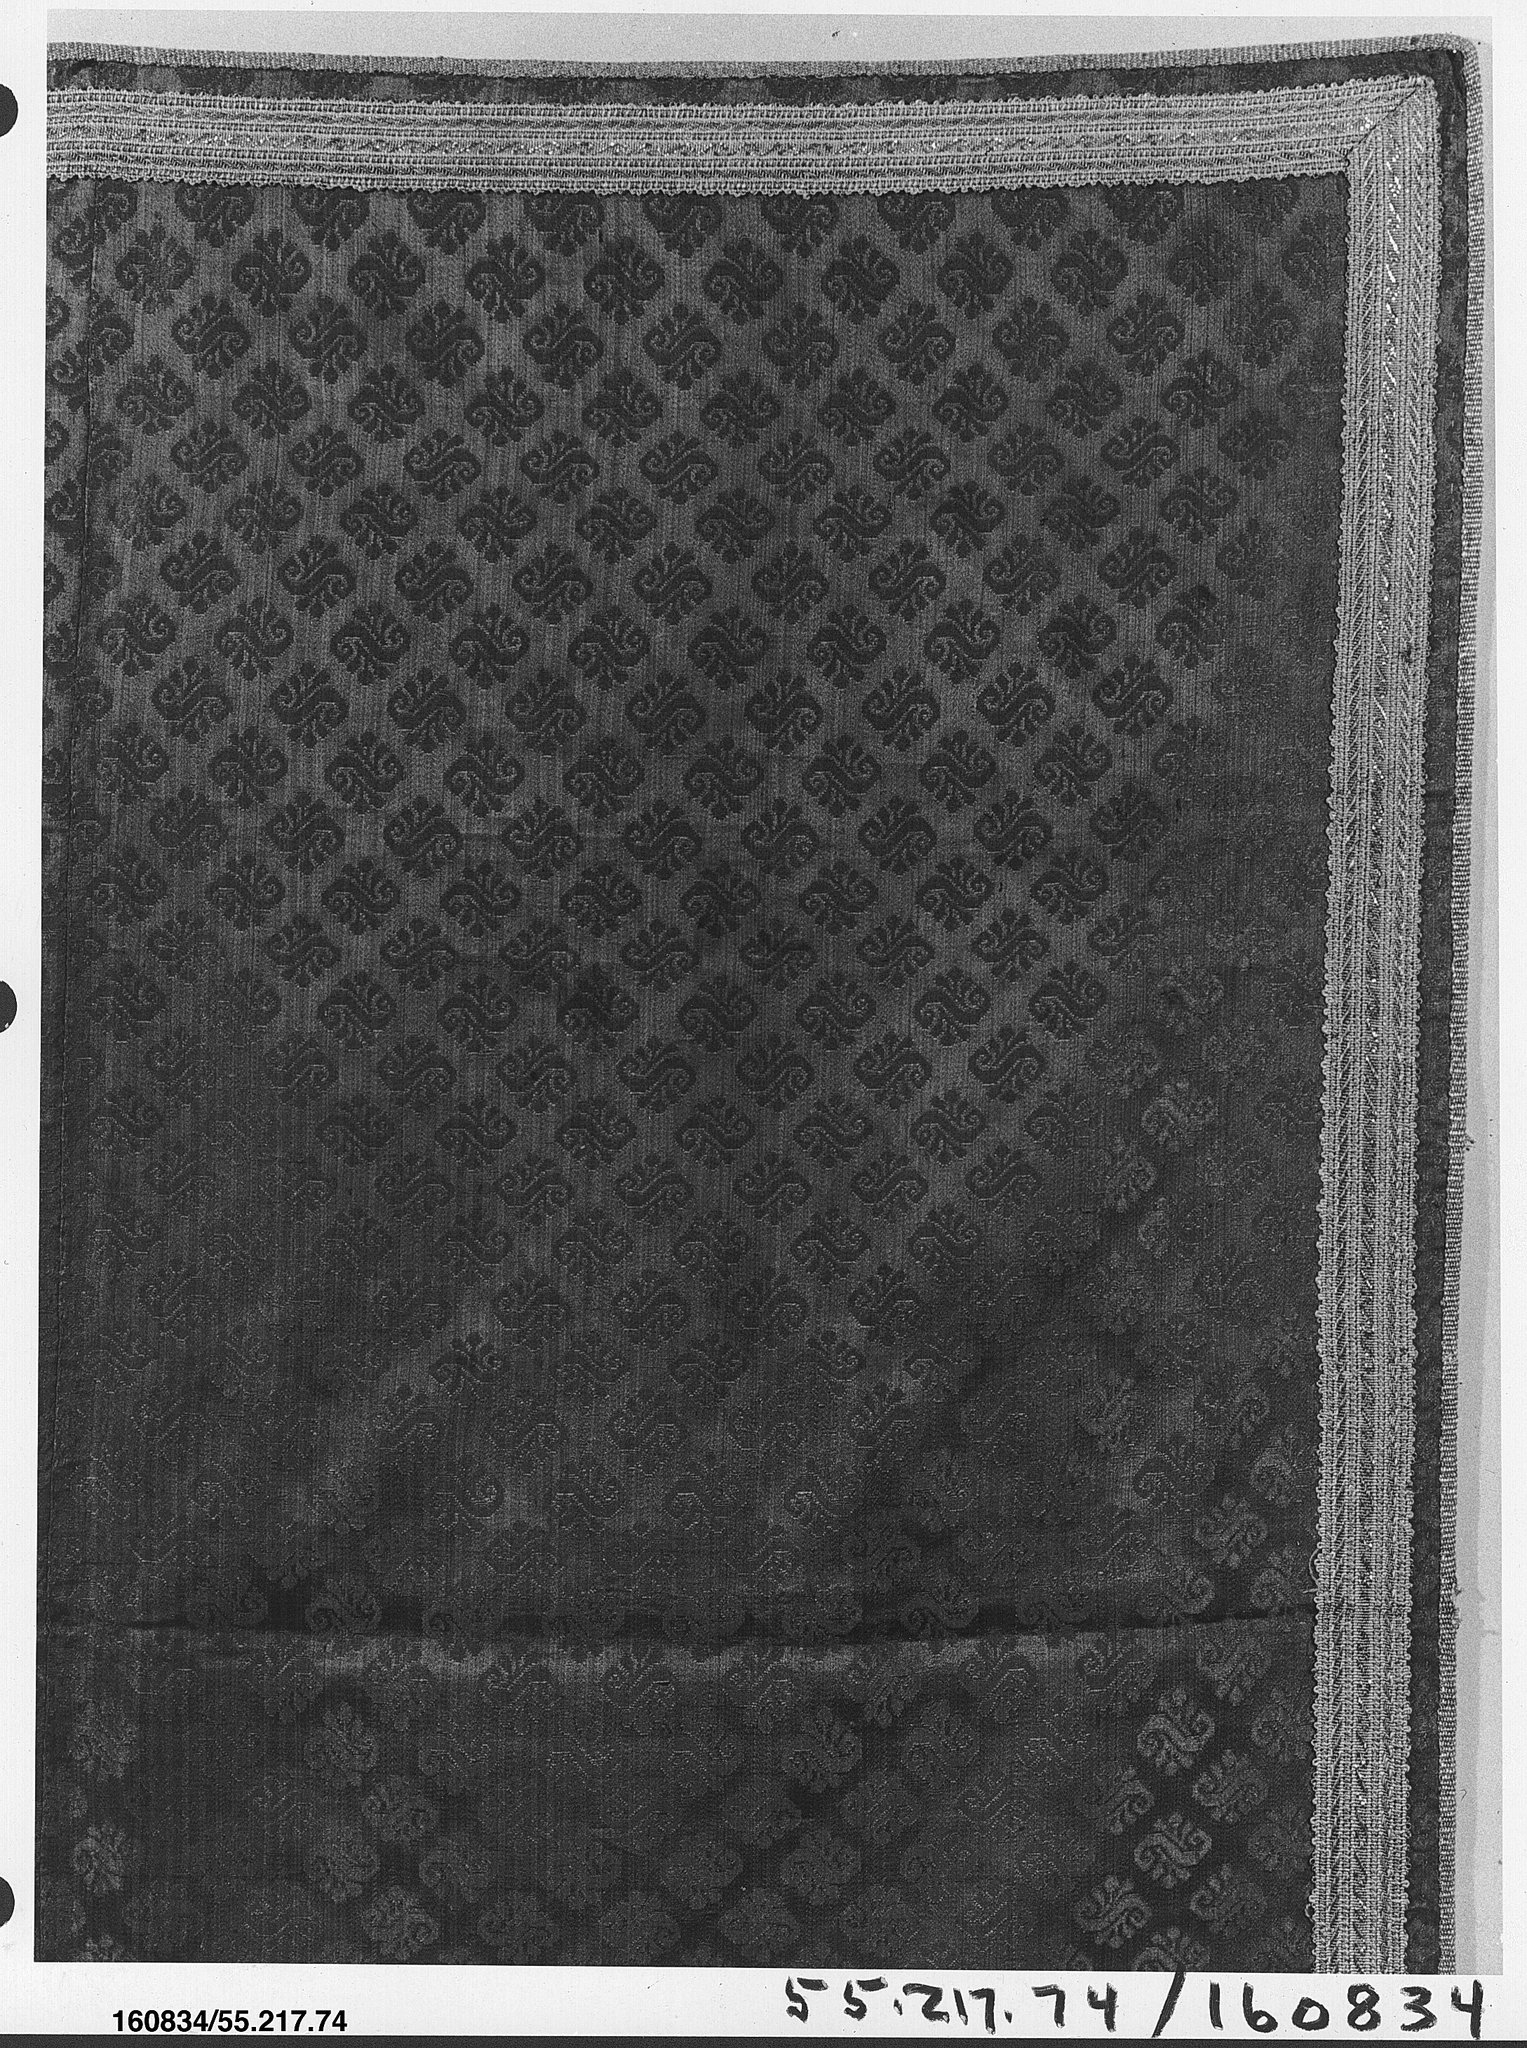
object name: piece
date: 1601-1700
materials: silk